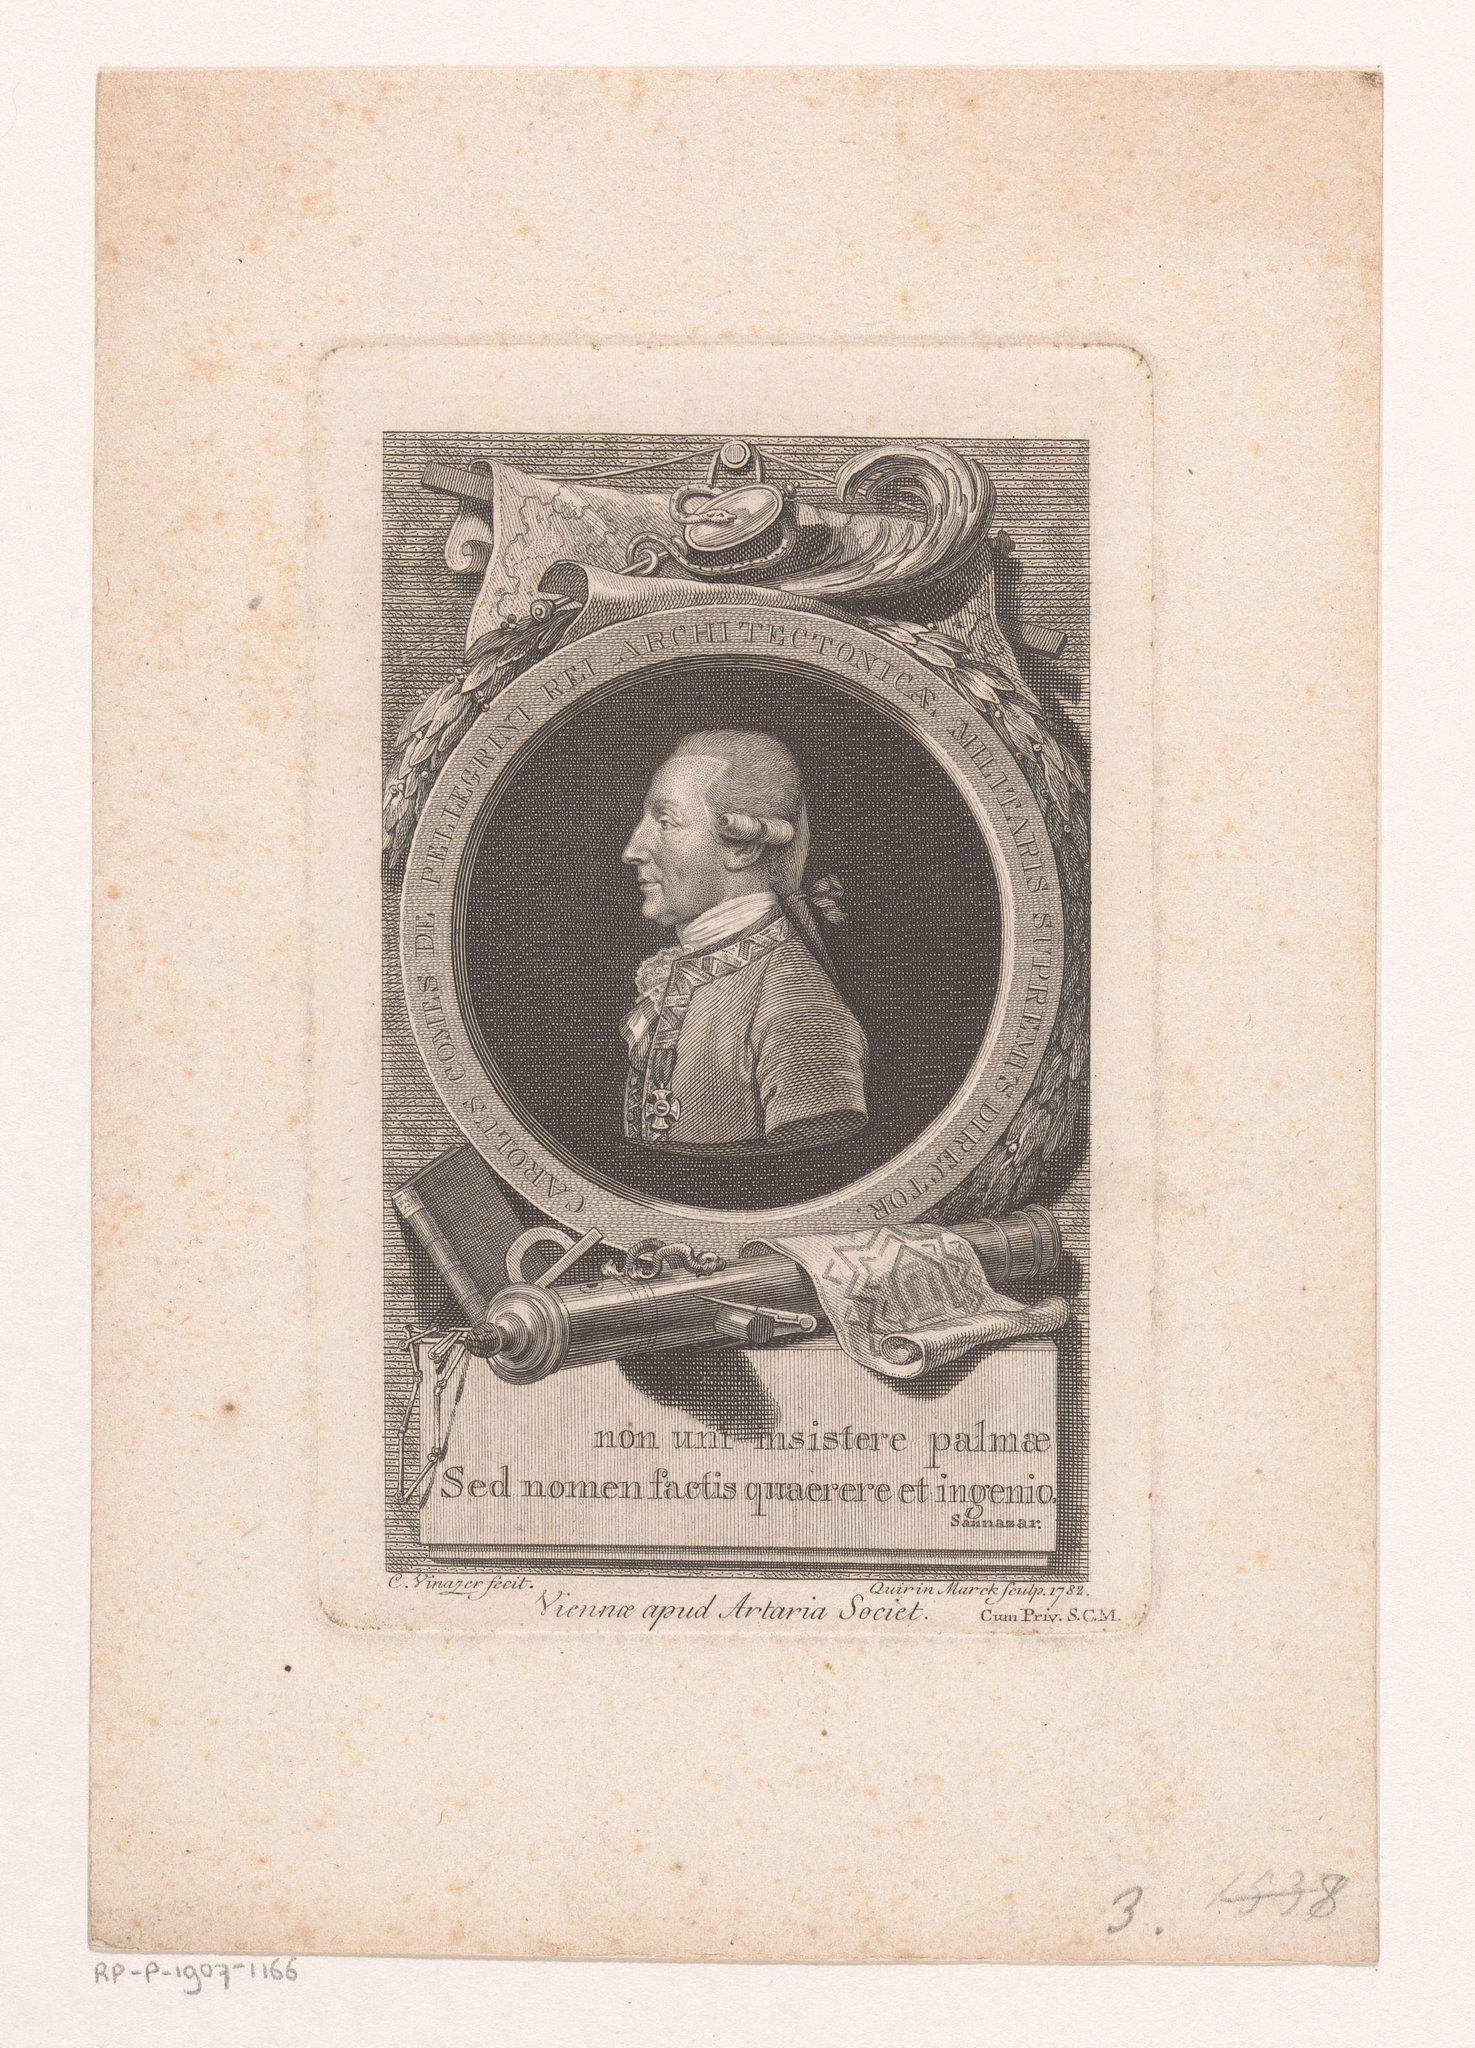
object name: print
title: Portret van Carl Clemens von Pellegrini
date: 1782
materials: paper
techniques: engraving, etching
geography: vienna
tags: vienna, historical persons, weapons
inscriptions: collector's mark: Lugt 2228, inscription: ‘No 1620’